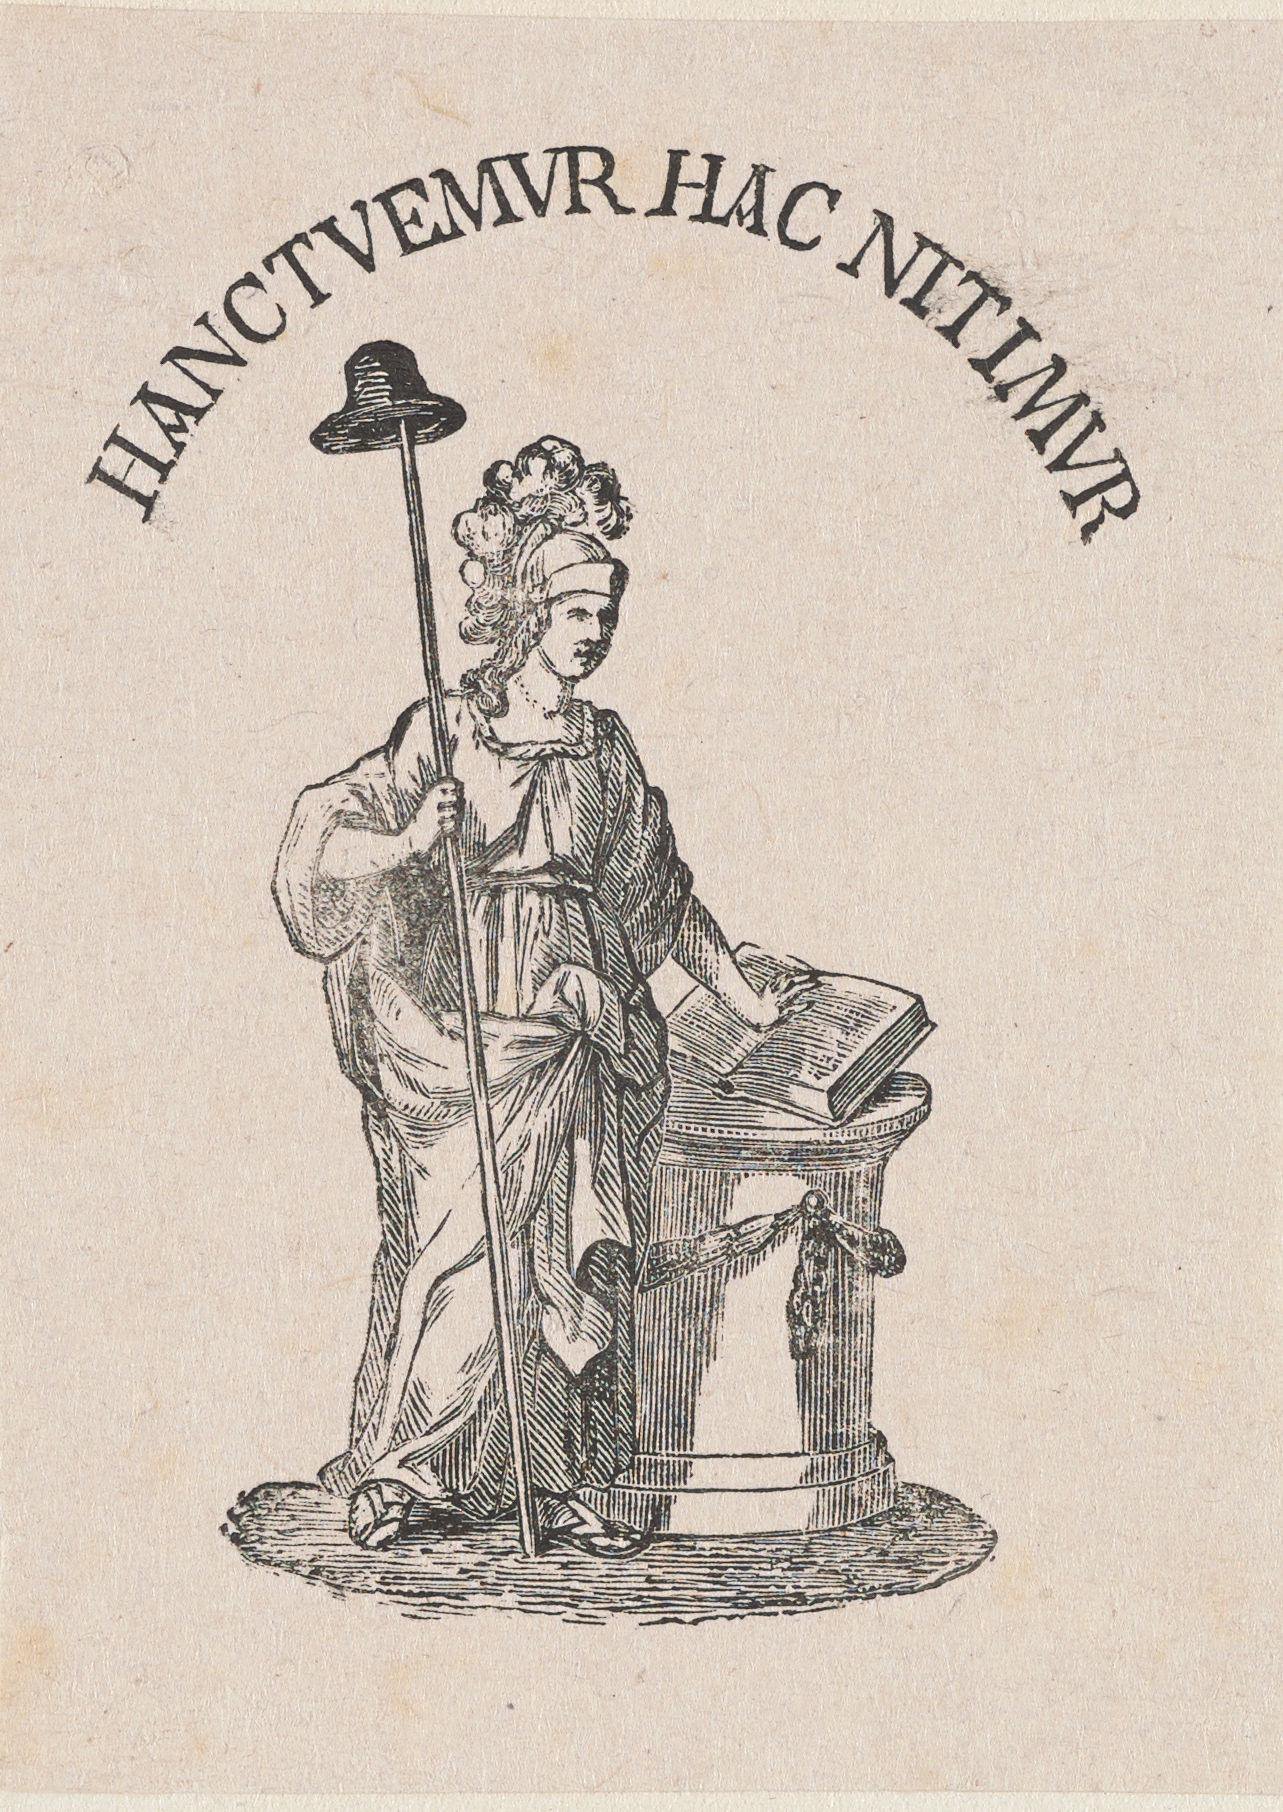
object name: print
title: Vignet met de Nederlandse Maagd met een vrijheidshoed op een lans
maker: isaac weissenbruch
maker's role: print maker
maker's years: 1826-1912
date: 1836-1912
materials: paper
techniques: engraving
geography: netherlands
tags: personifications of countries, nations, states, districts, etc., vignette